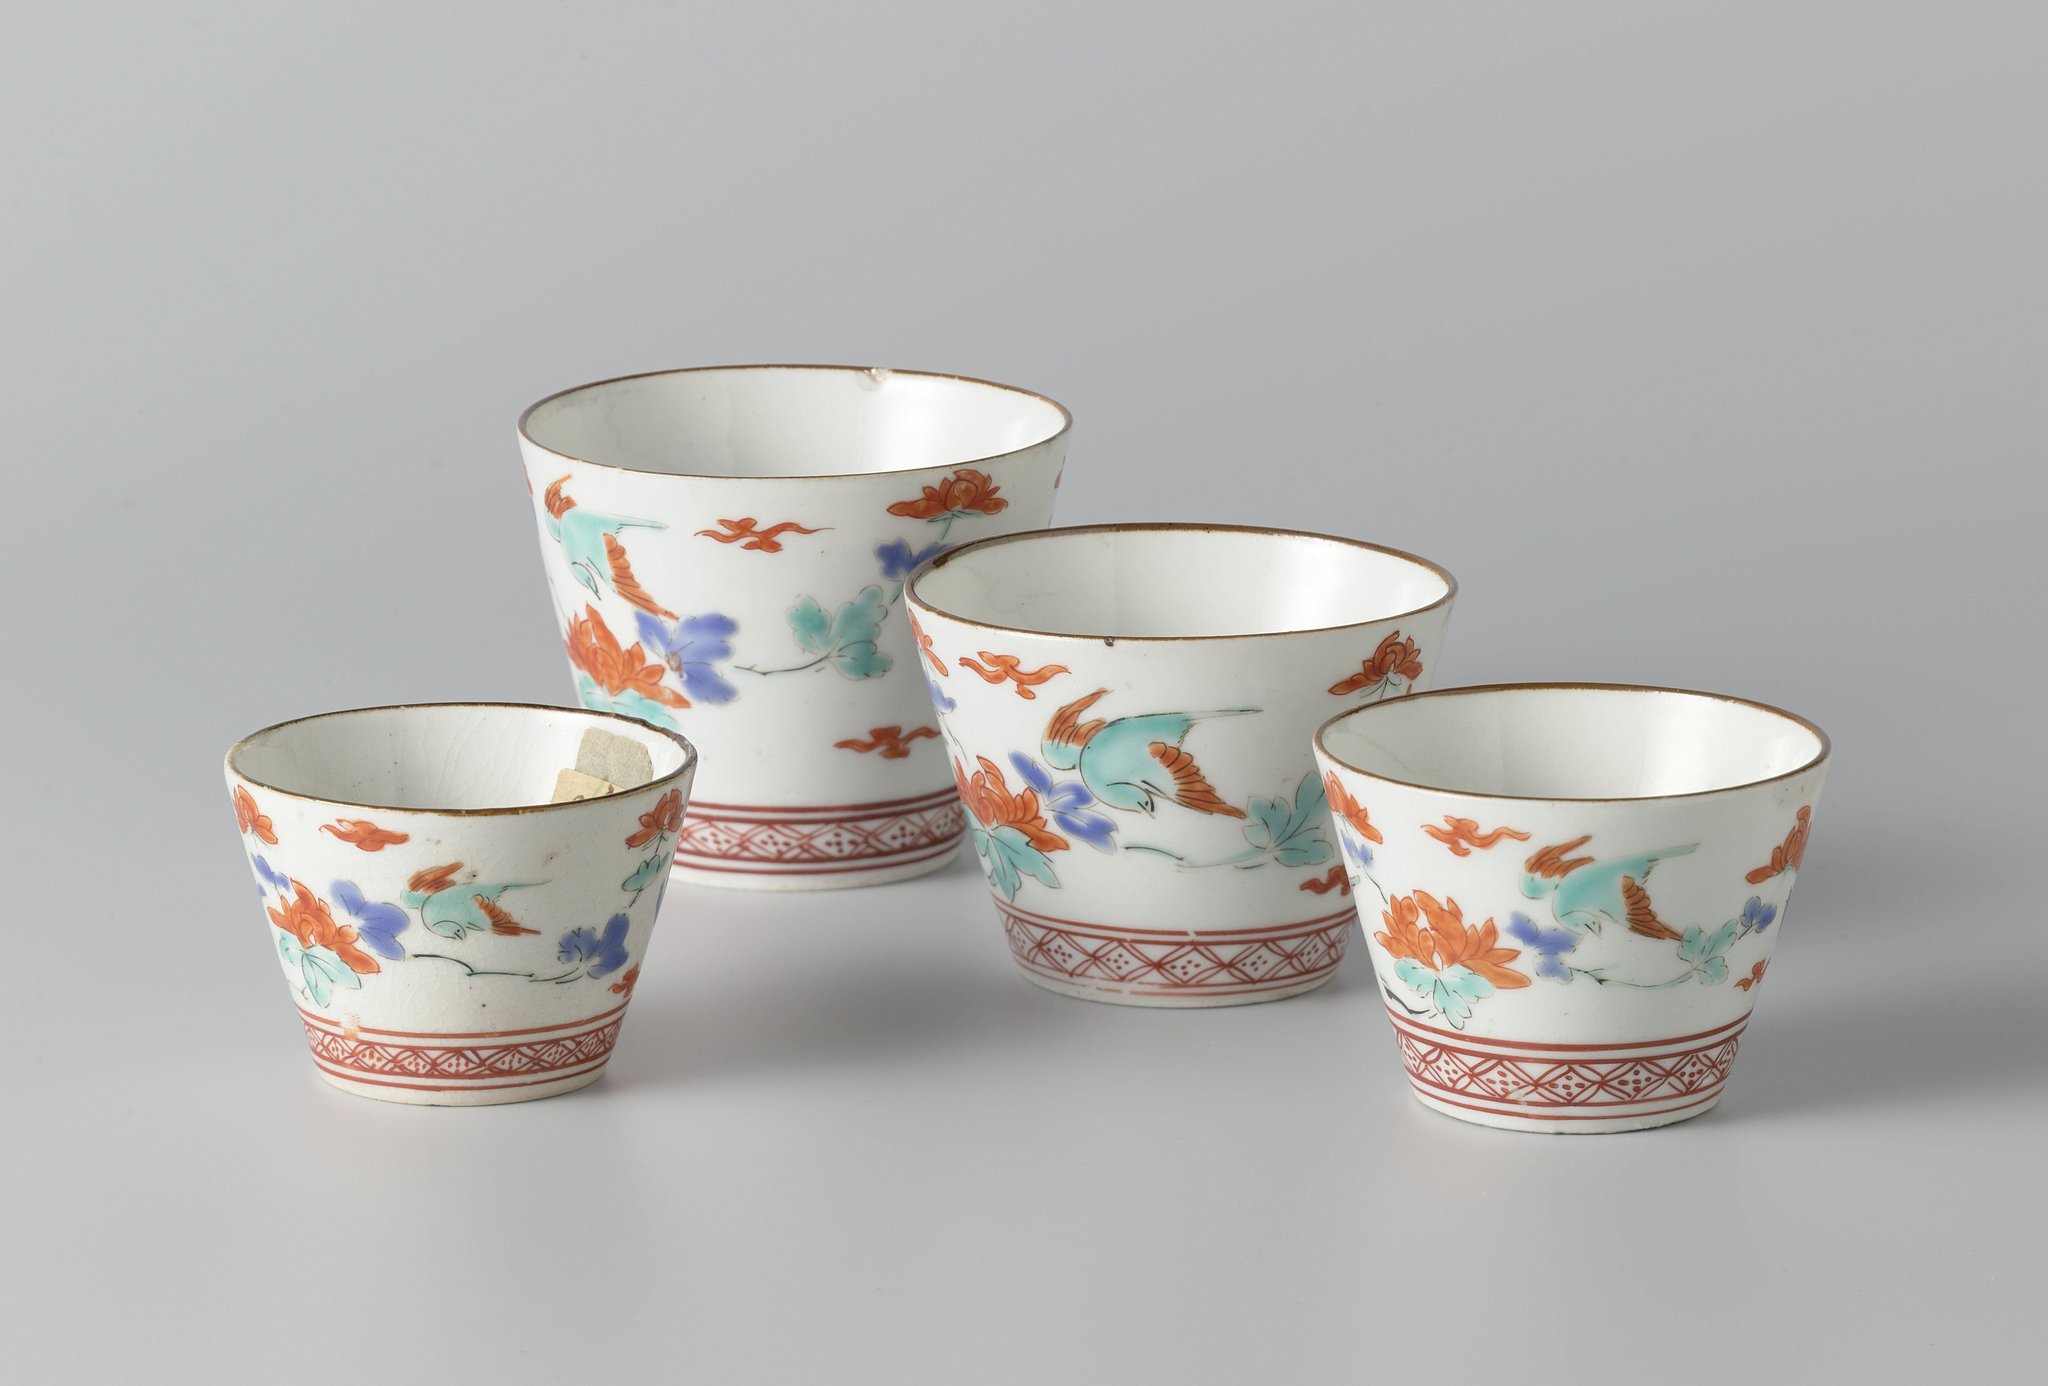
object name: bowl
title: Bowl with birds and flower sprays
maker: Anonymous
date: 1670-1690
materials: glaze, paint, porcelain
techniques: firing, turning, vitrification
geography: arita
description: Japanese porcelain with decoration in the Kakiemon style. Set of four cups c. 1700 - 1725.